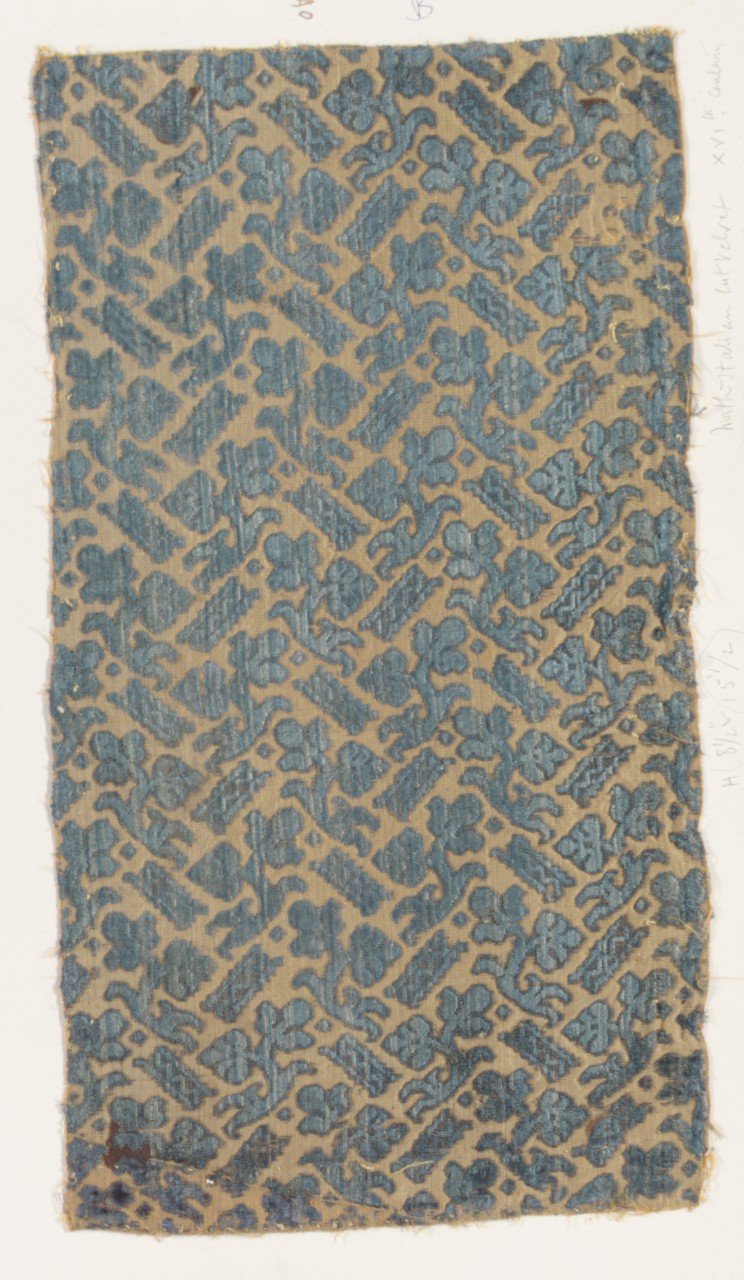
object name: fragment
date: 1501-1600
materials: silk